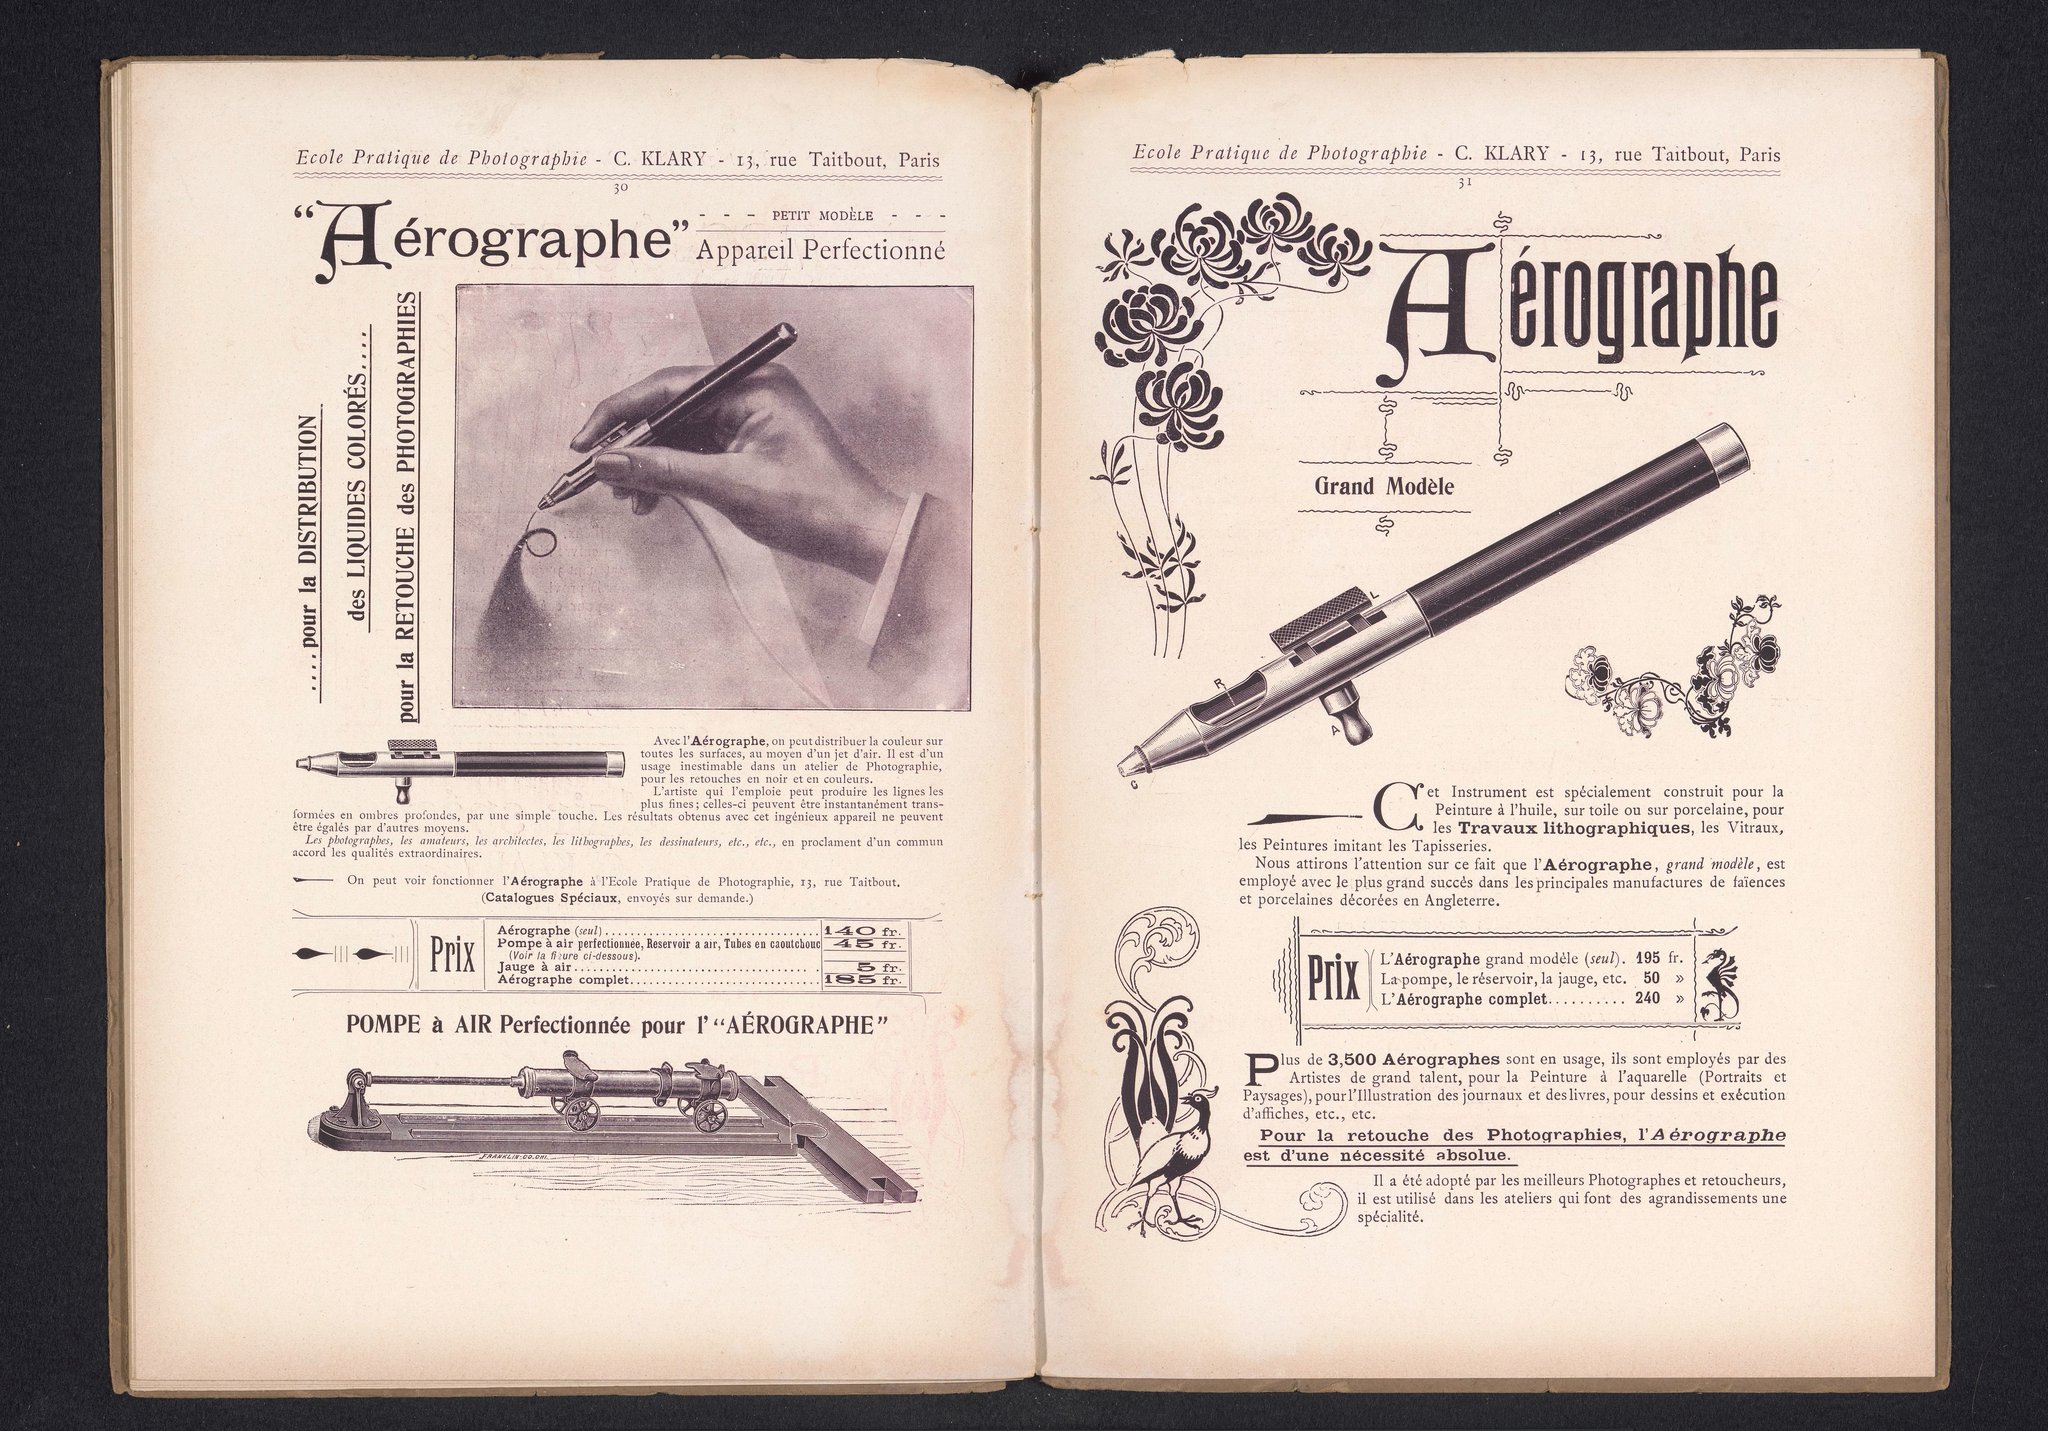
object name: page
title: Fotoreproductie van een tekening van het gebruik van een apparaat om foto's mee te kleuren en te retoucheren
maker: charles louis klary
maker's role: fotograaf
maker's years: 1837-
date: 1890-1900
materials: paper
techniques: autotype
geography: paris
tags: colours, pigments, and paints